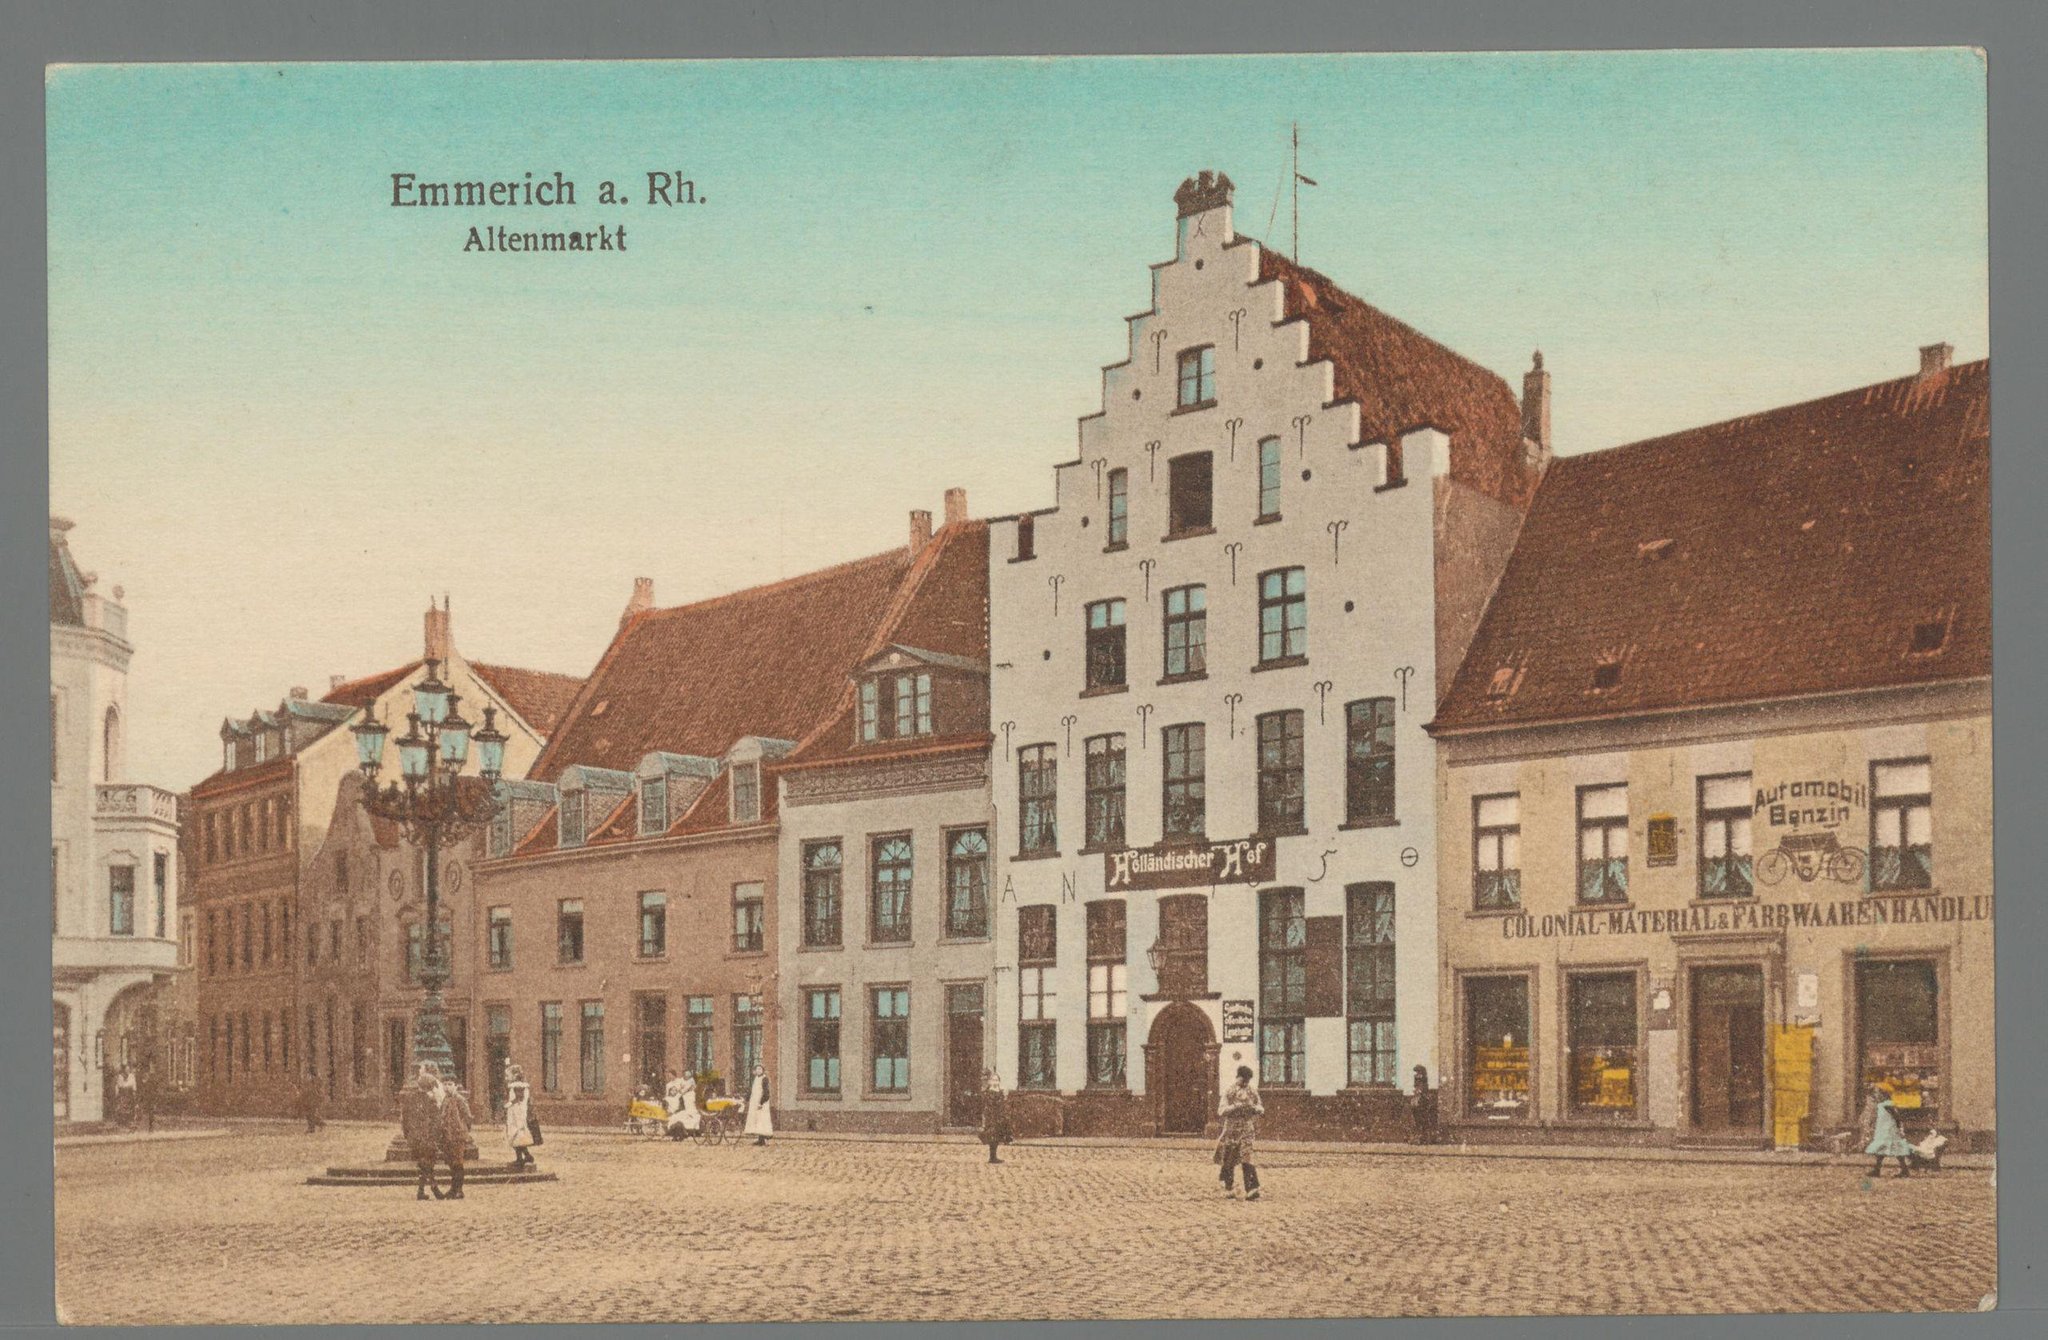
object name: photomechanical print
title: Emmerich a. Rh. Altenmarkt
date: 1905-1930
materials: cardboard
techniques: photograph, lithograph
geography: emmerik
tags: square, place, circus, etc.